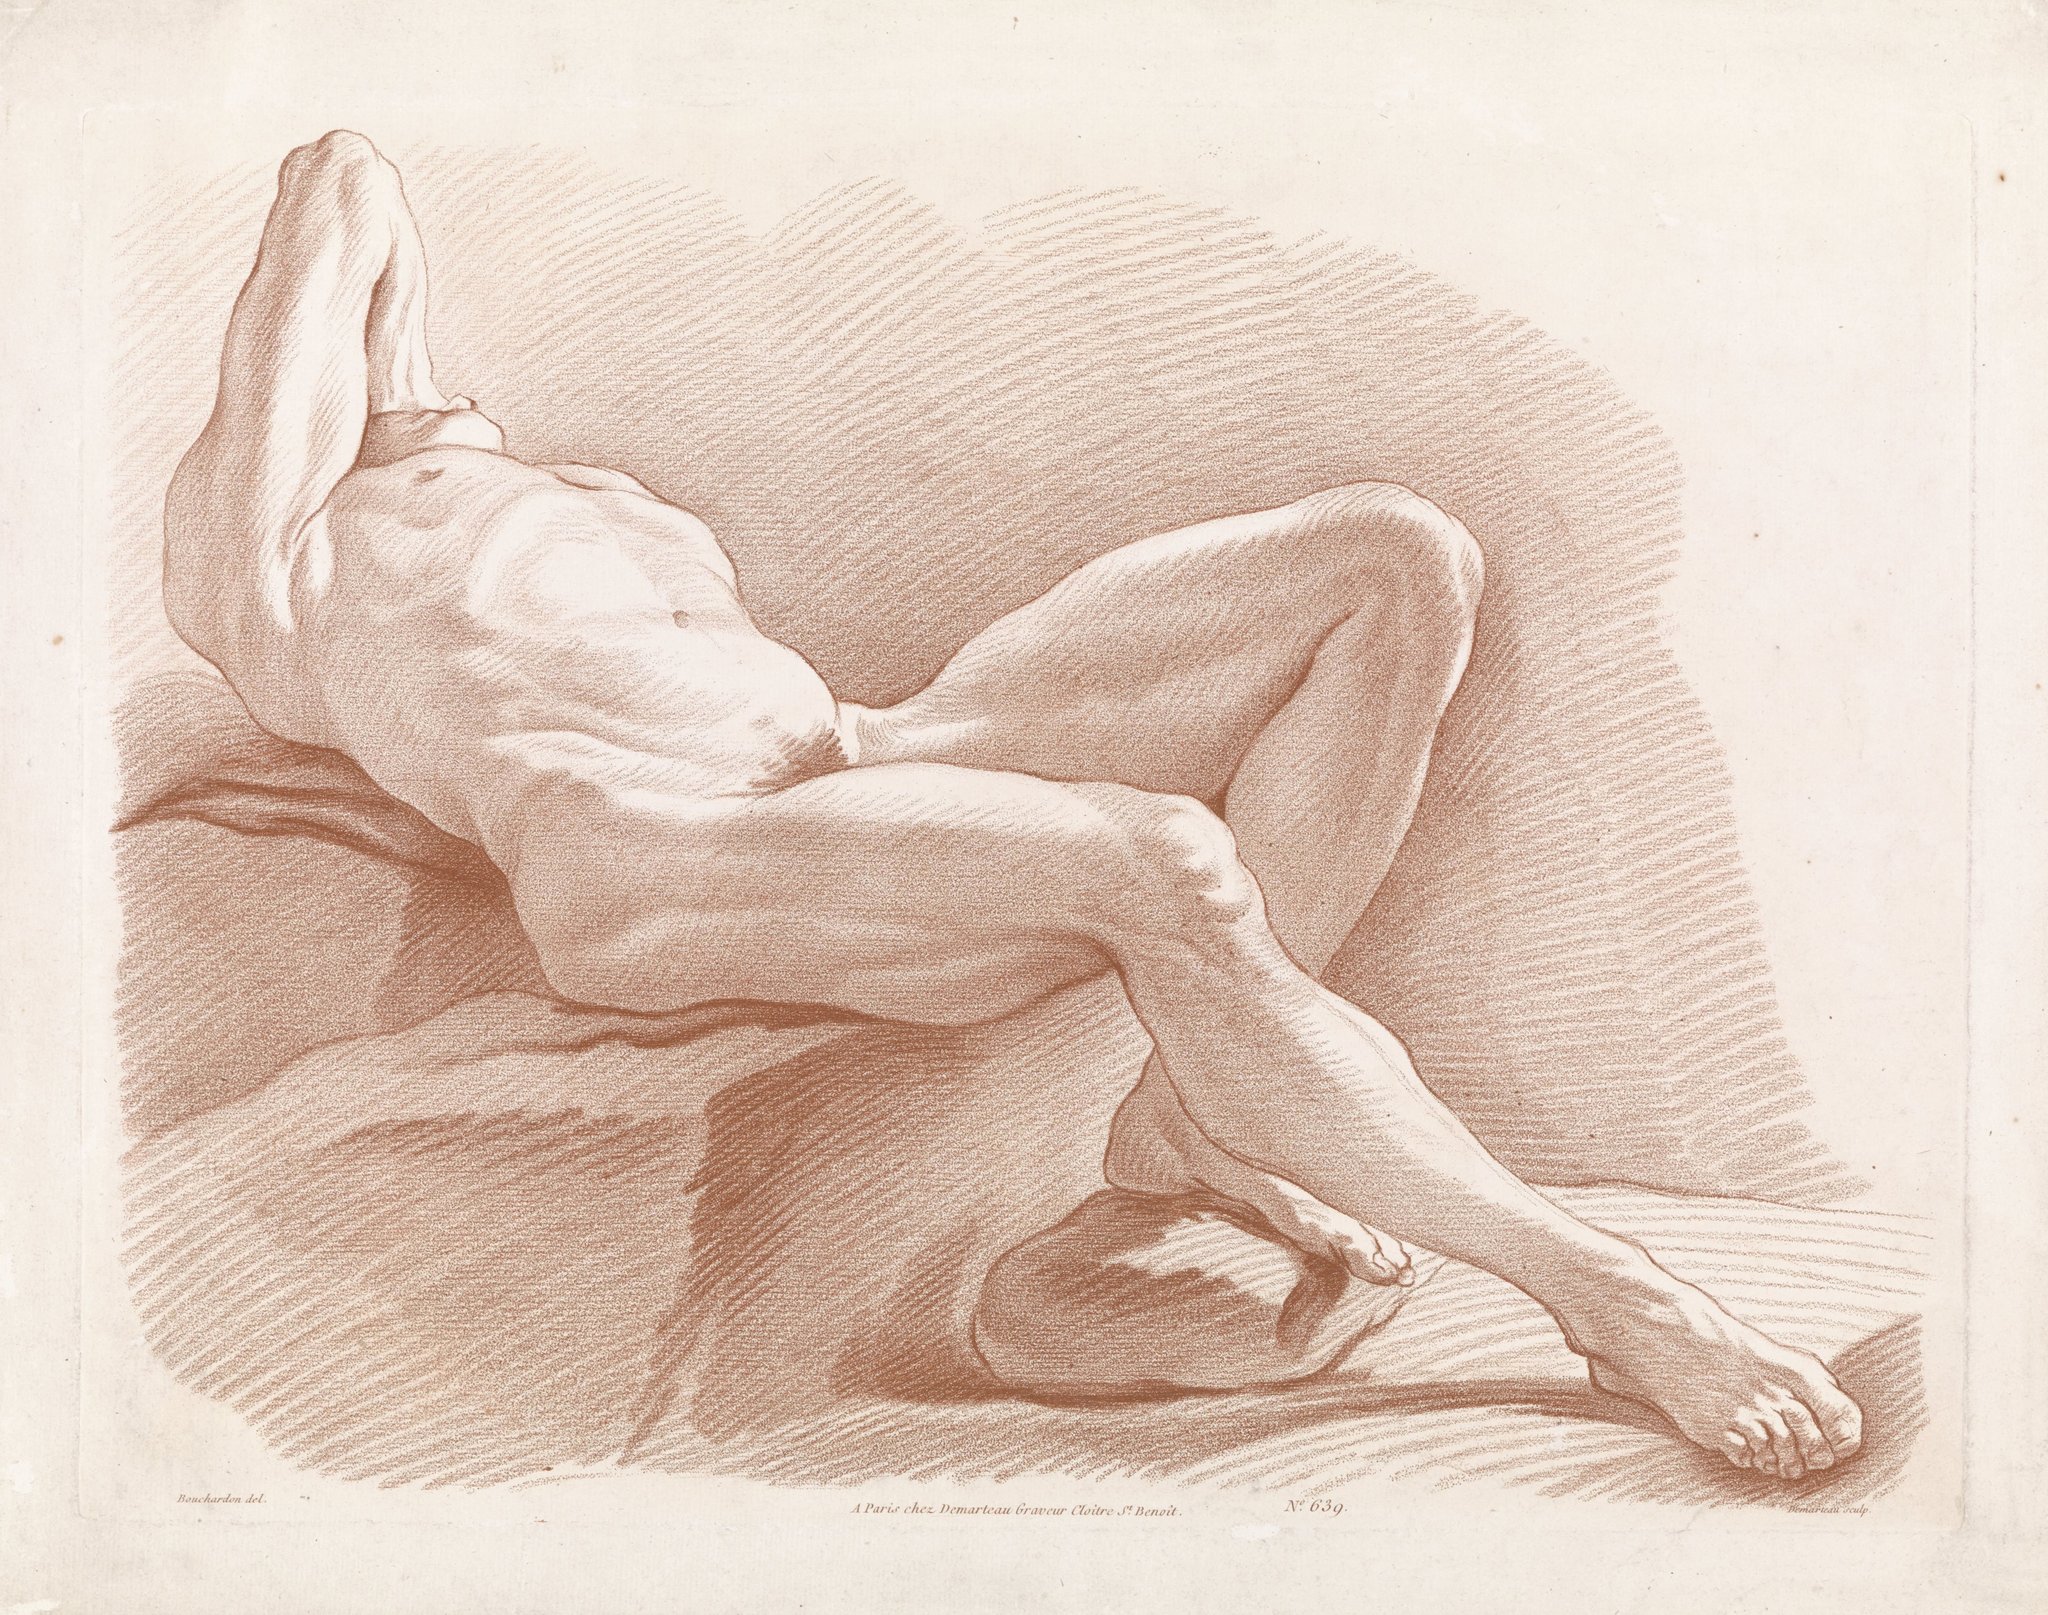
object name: print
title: Liggend mannelijke naakt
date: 1732-1776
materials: paper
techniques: printmaking, etching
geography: paris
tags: human figure of ideal proportions, e.g. academic nude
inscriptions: collector's mark: Lugt 2228